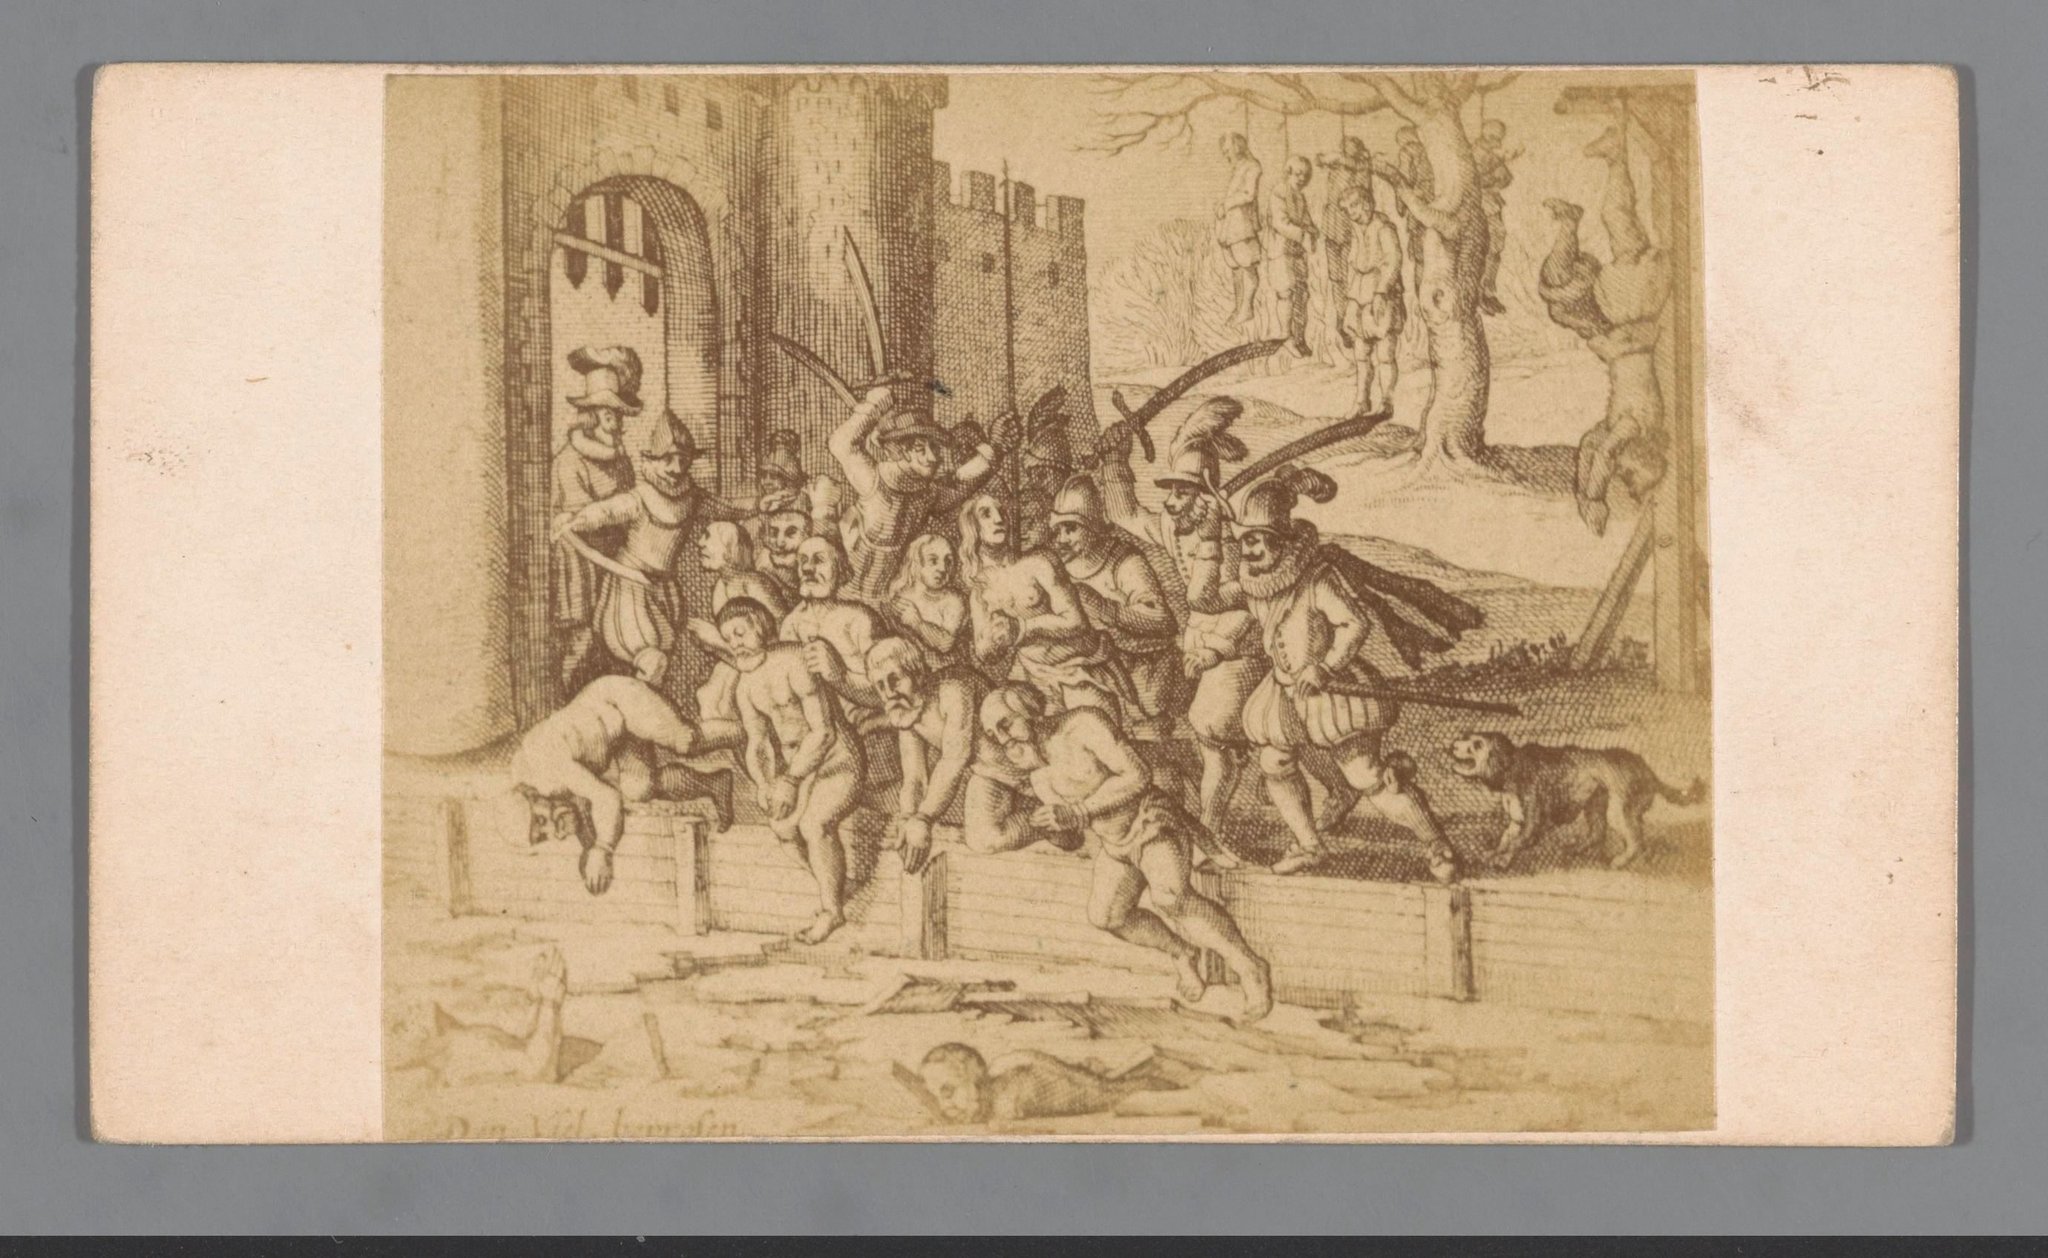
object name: reproduction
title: Fotoreproductie van een gravure van de uitmoording van Zutphen door de Spanjaarden in 1572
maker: Anonymous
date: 1850-1900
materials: cardboard, photographic support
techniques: albumen print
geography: netherlands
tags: murder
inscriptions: inscription: ‘Zutphen door (...) brand gestoken.’, number: ‘15’